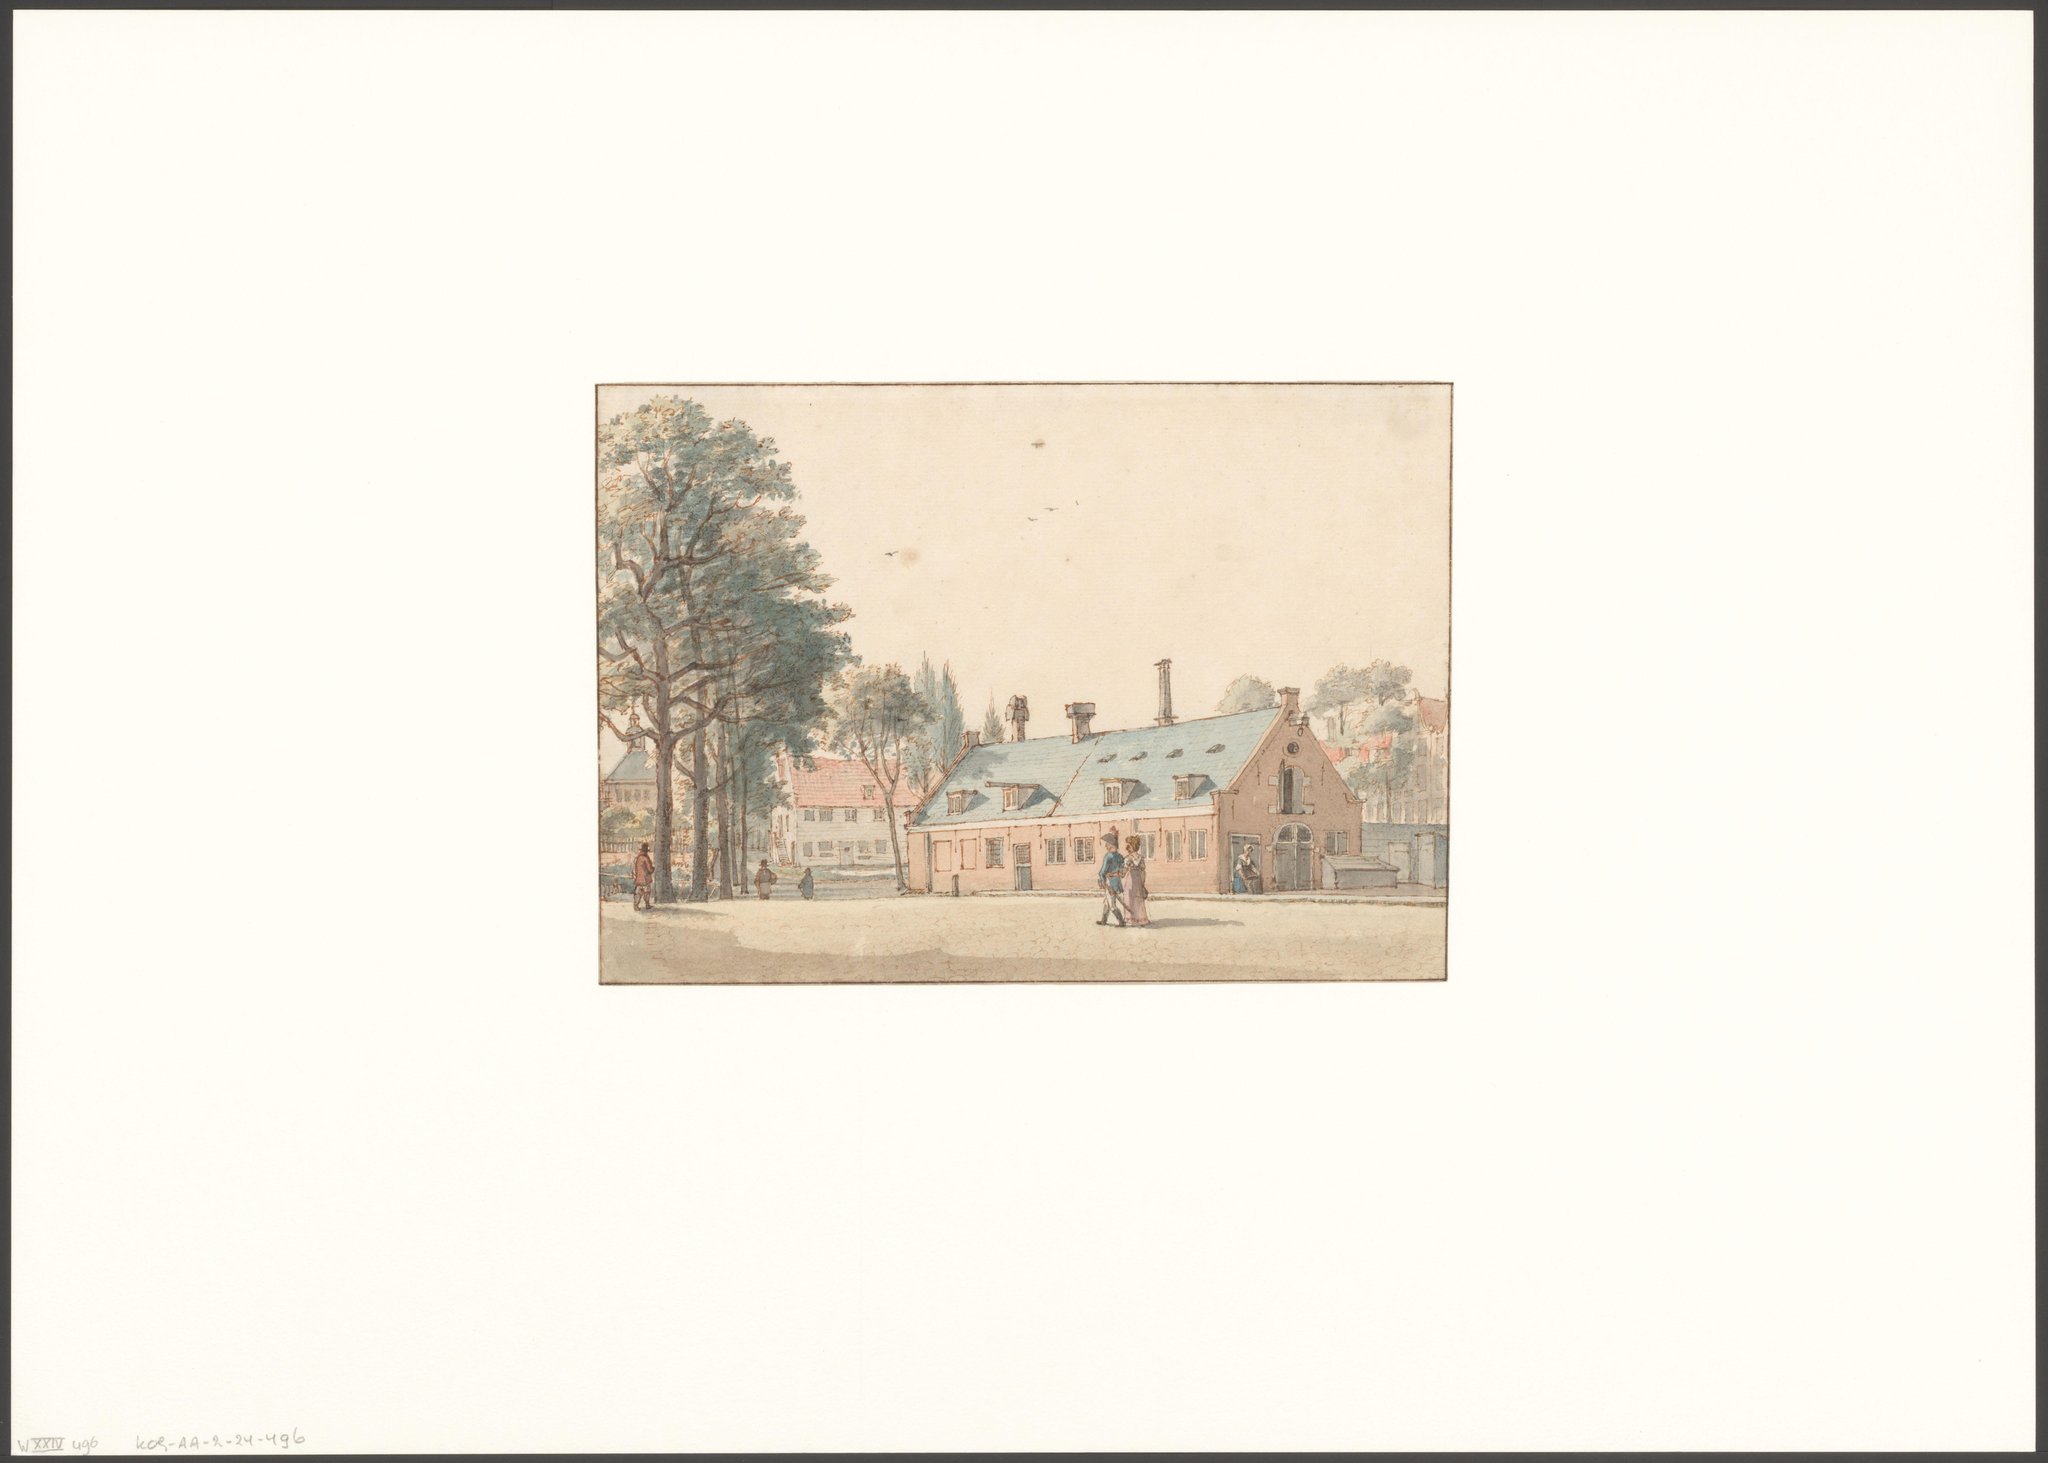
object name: drawing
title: Gezicht op het Frederiksplein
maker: gerrit lamberts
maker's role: bookseller, draughtsman, print maker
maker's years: 1776-1850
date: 1817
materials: ink, paper, pencil, watercolor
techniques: brush, pen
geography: amsterdam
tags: square, place, circus, etc., city-view in general; 'veduta'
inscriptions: collector's mark: Lugt 800a, signature and date: ‘G. Lamberts. 1817.’, inscription: ‘Gezigt van de (...) Barak en / Utrechtschepoort.’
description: Tekening binnen de Atlas Van Eck ingedeeld op wijknummer 24.